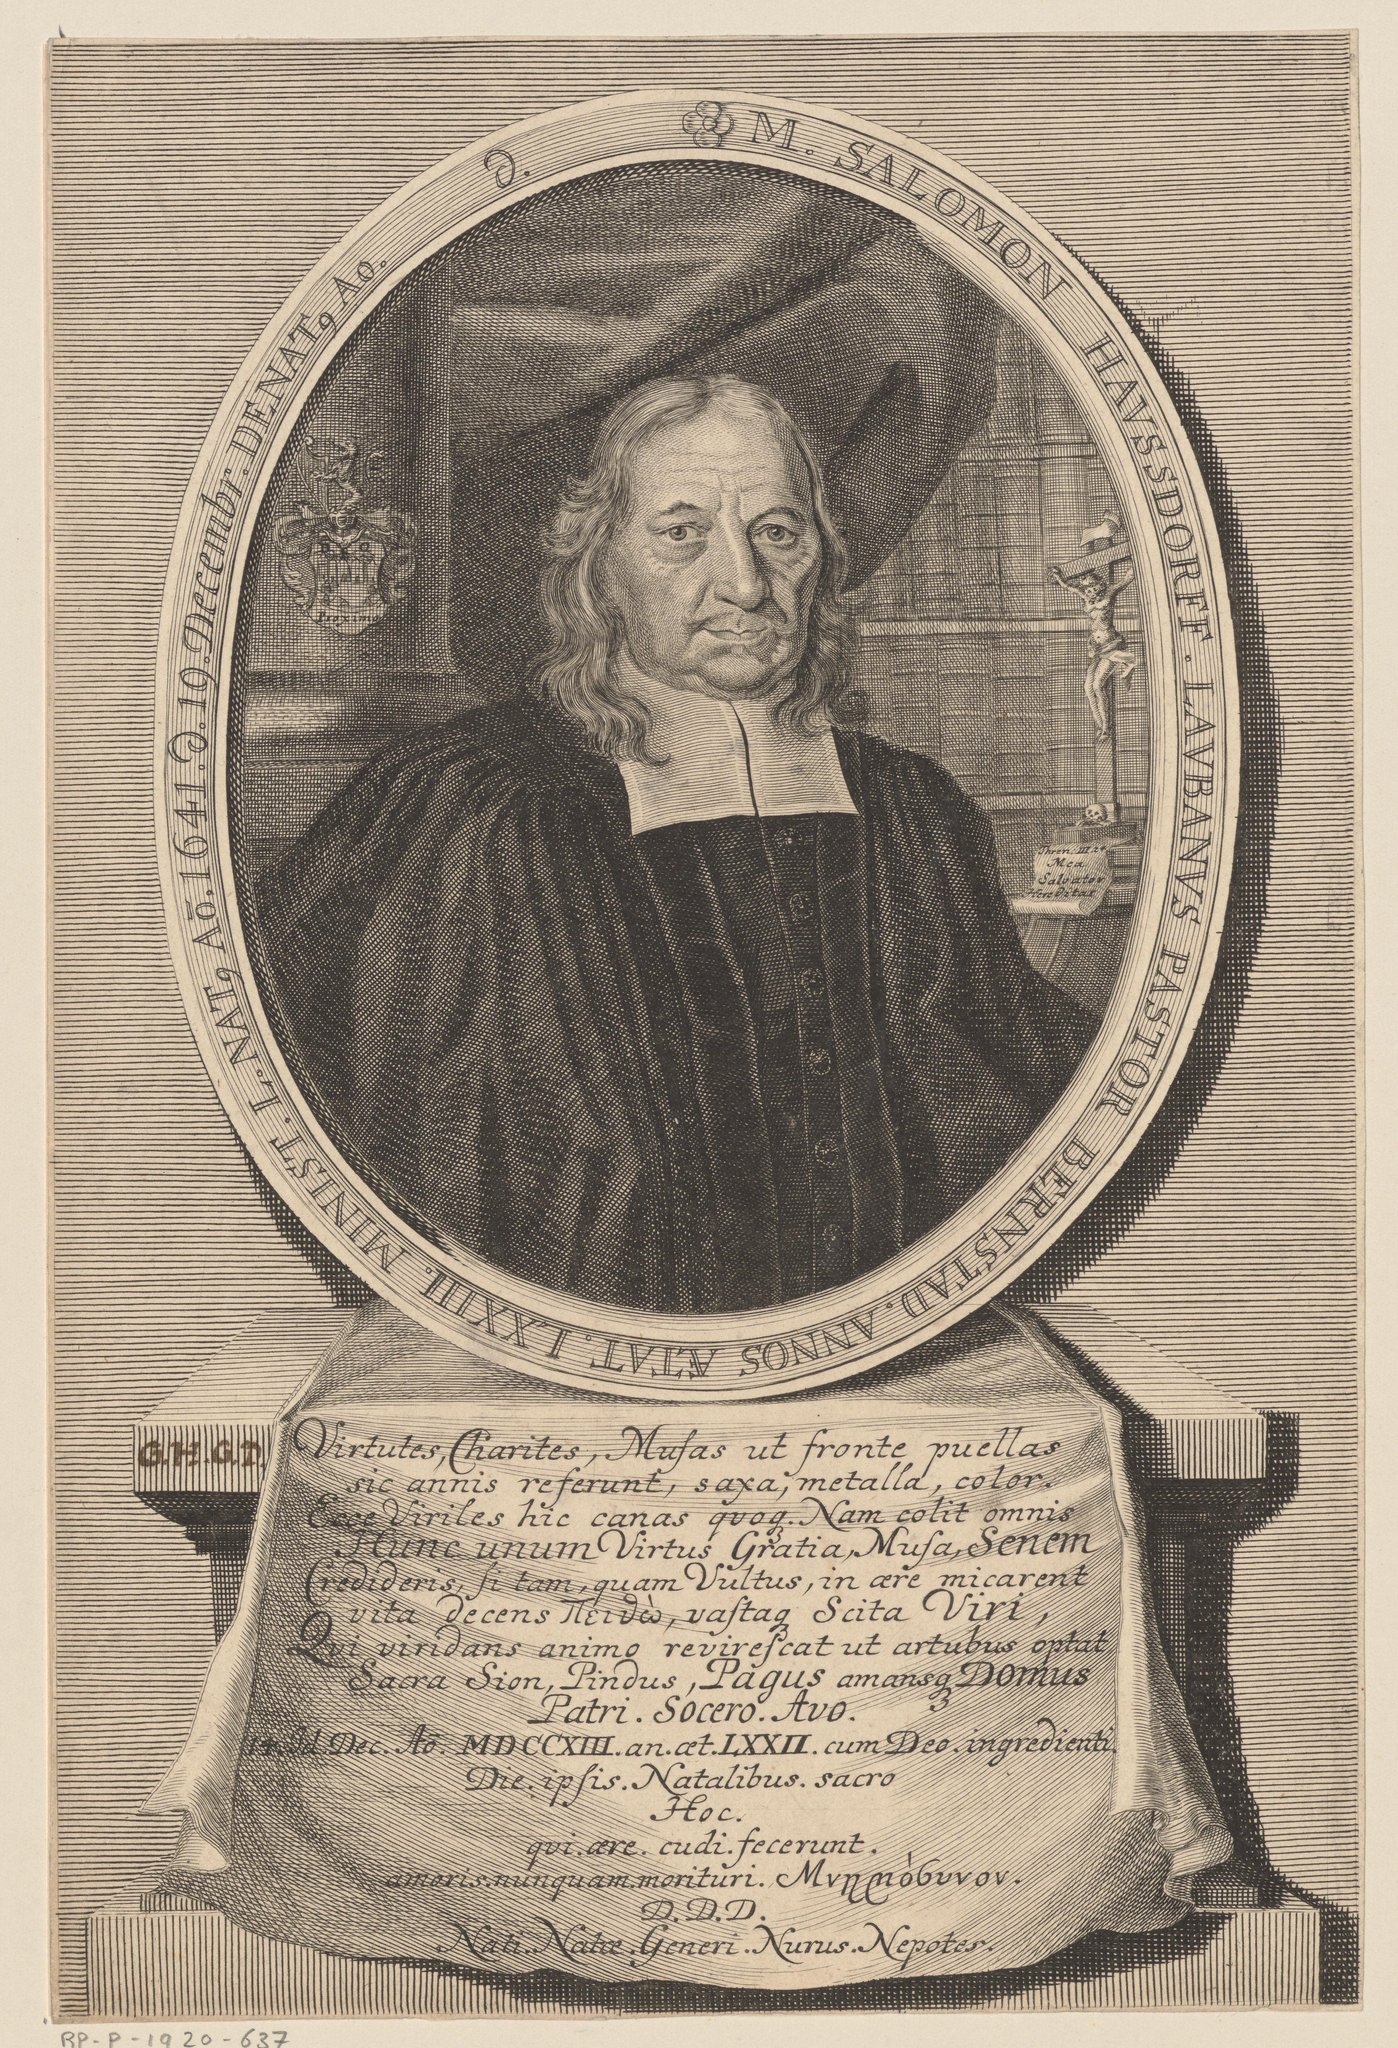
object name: print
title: Portret van Salomon Hausdorf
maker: martin bernigeroth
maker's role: print maker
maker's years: 1670-1733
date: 1713-1733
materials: paper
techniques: engraving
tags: theologian, historical persons, armorial bearing, heraldry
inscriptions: collector's mark: Lugt 2228